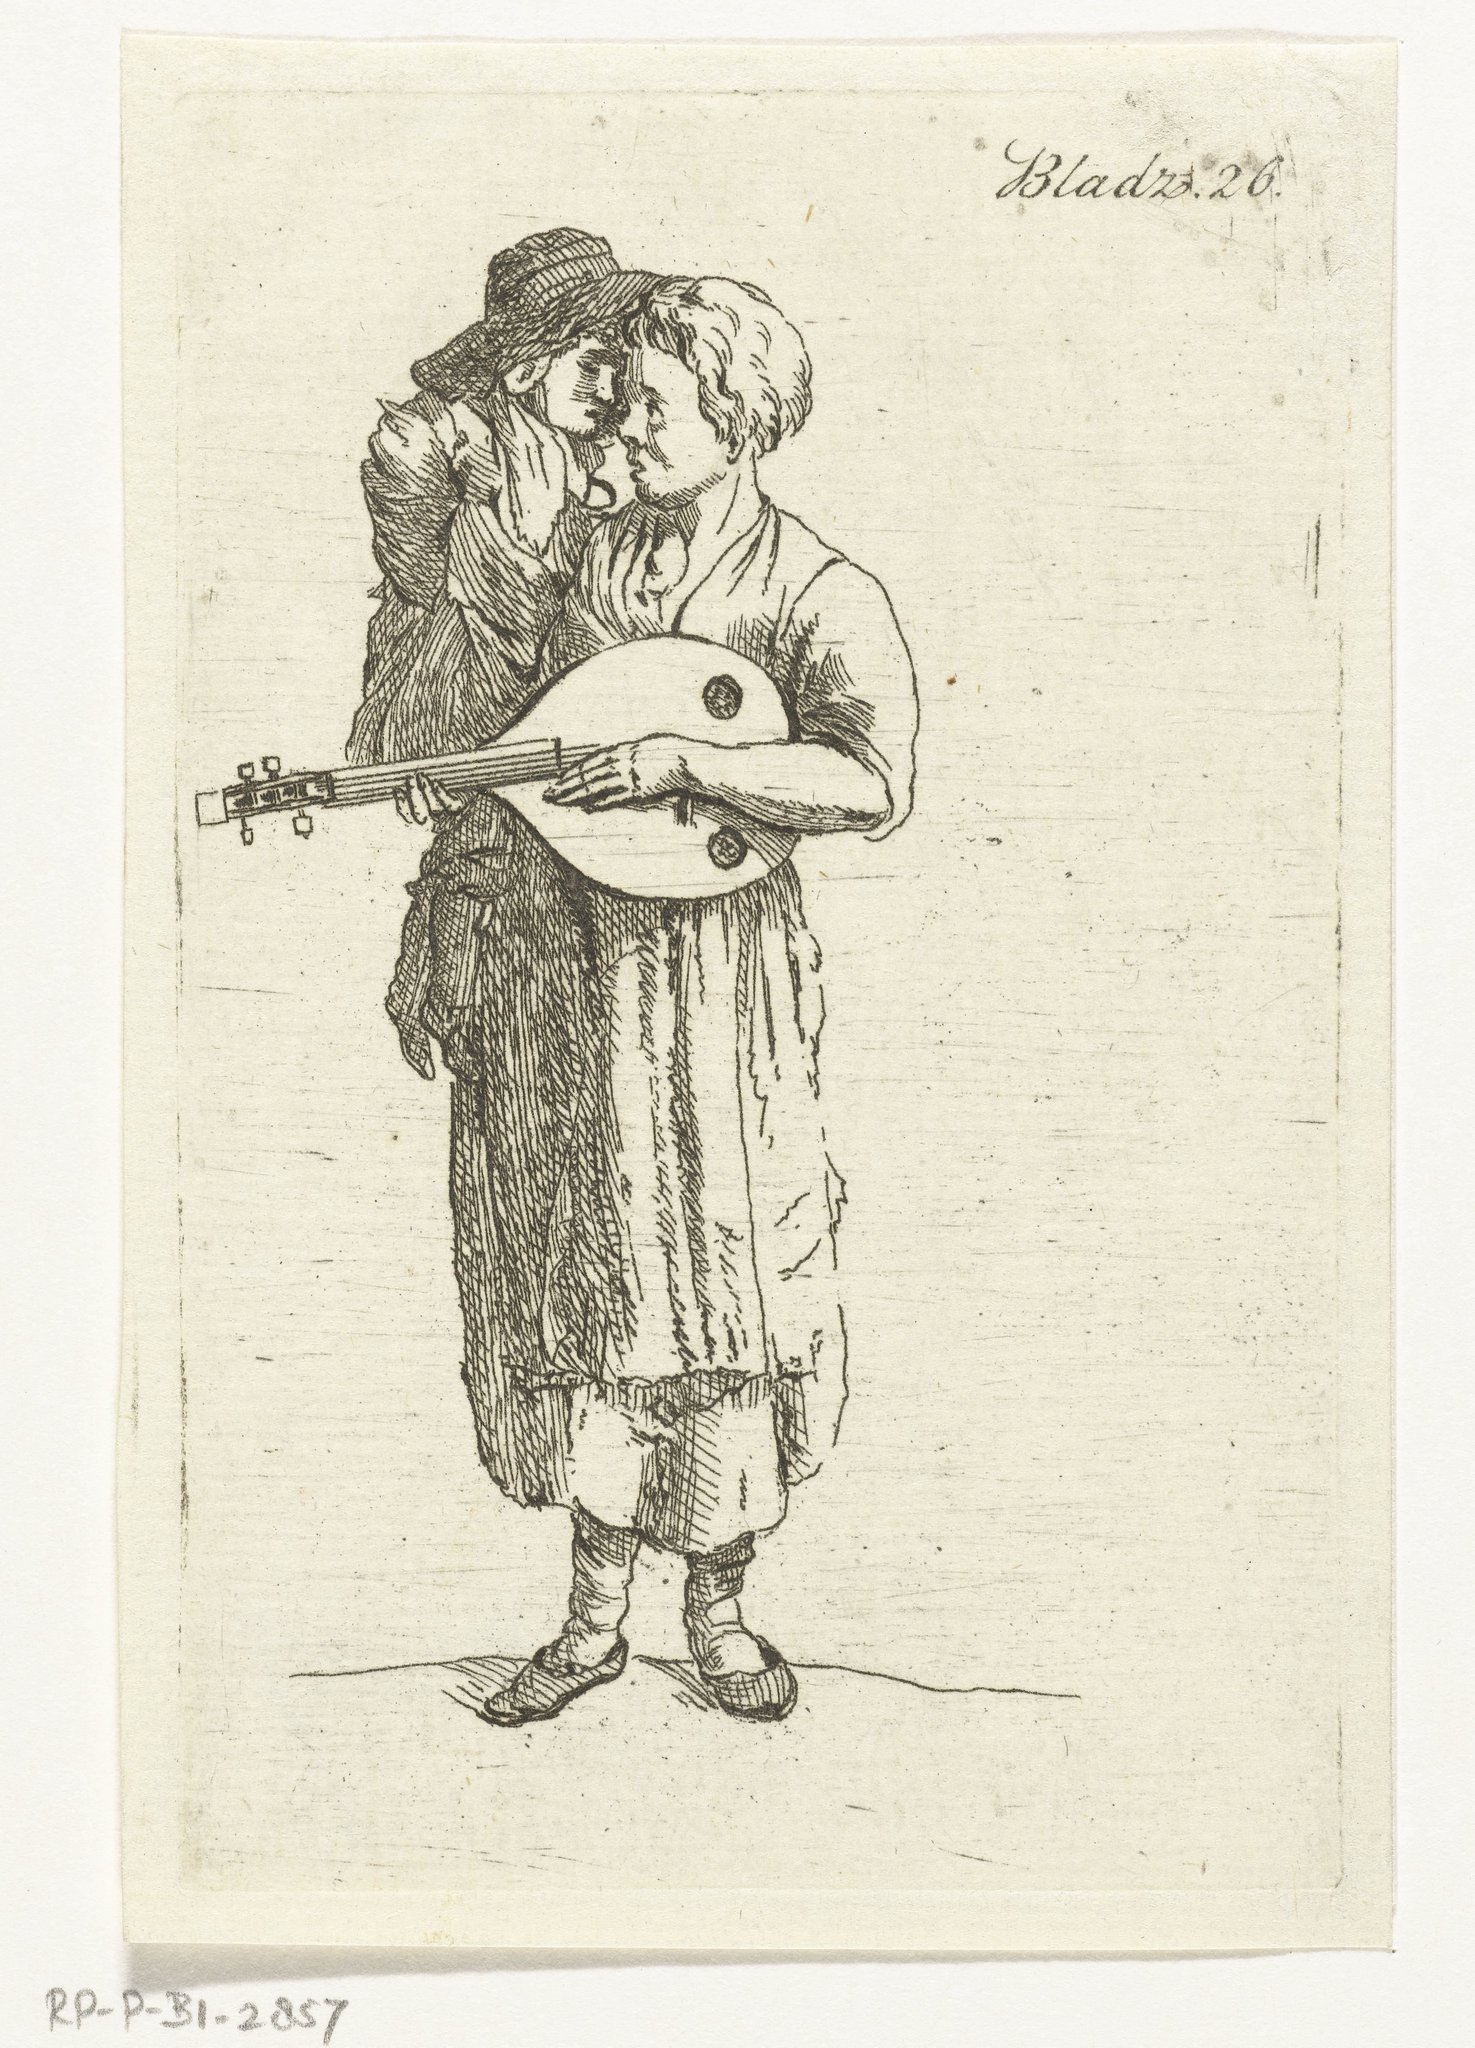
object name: print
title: Staande figuren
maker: anthonie van den bos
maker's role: draughtsman, print maker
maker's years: 1763-1838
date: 1778-1838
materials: paper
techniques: etching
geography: netherlands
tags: puppet, minstrel, 'jongleur', standing figure (canon, proportions)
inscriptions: collector's mark: Lugt 2228